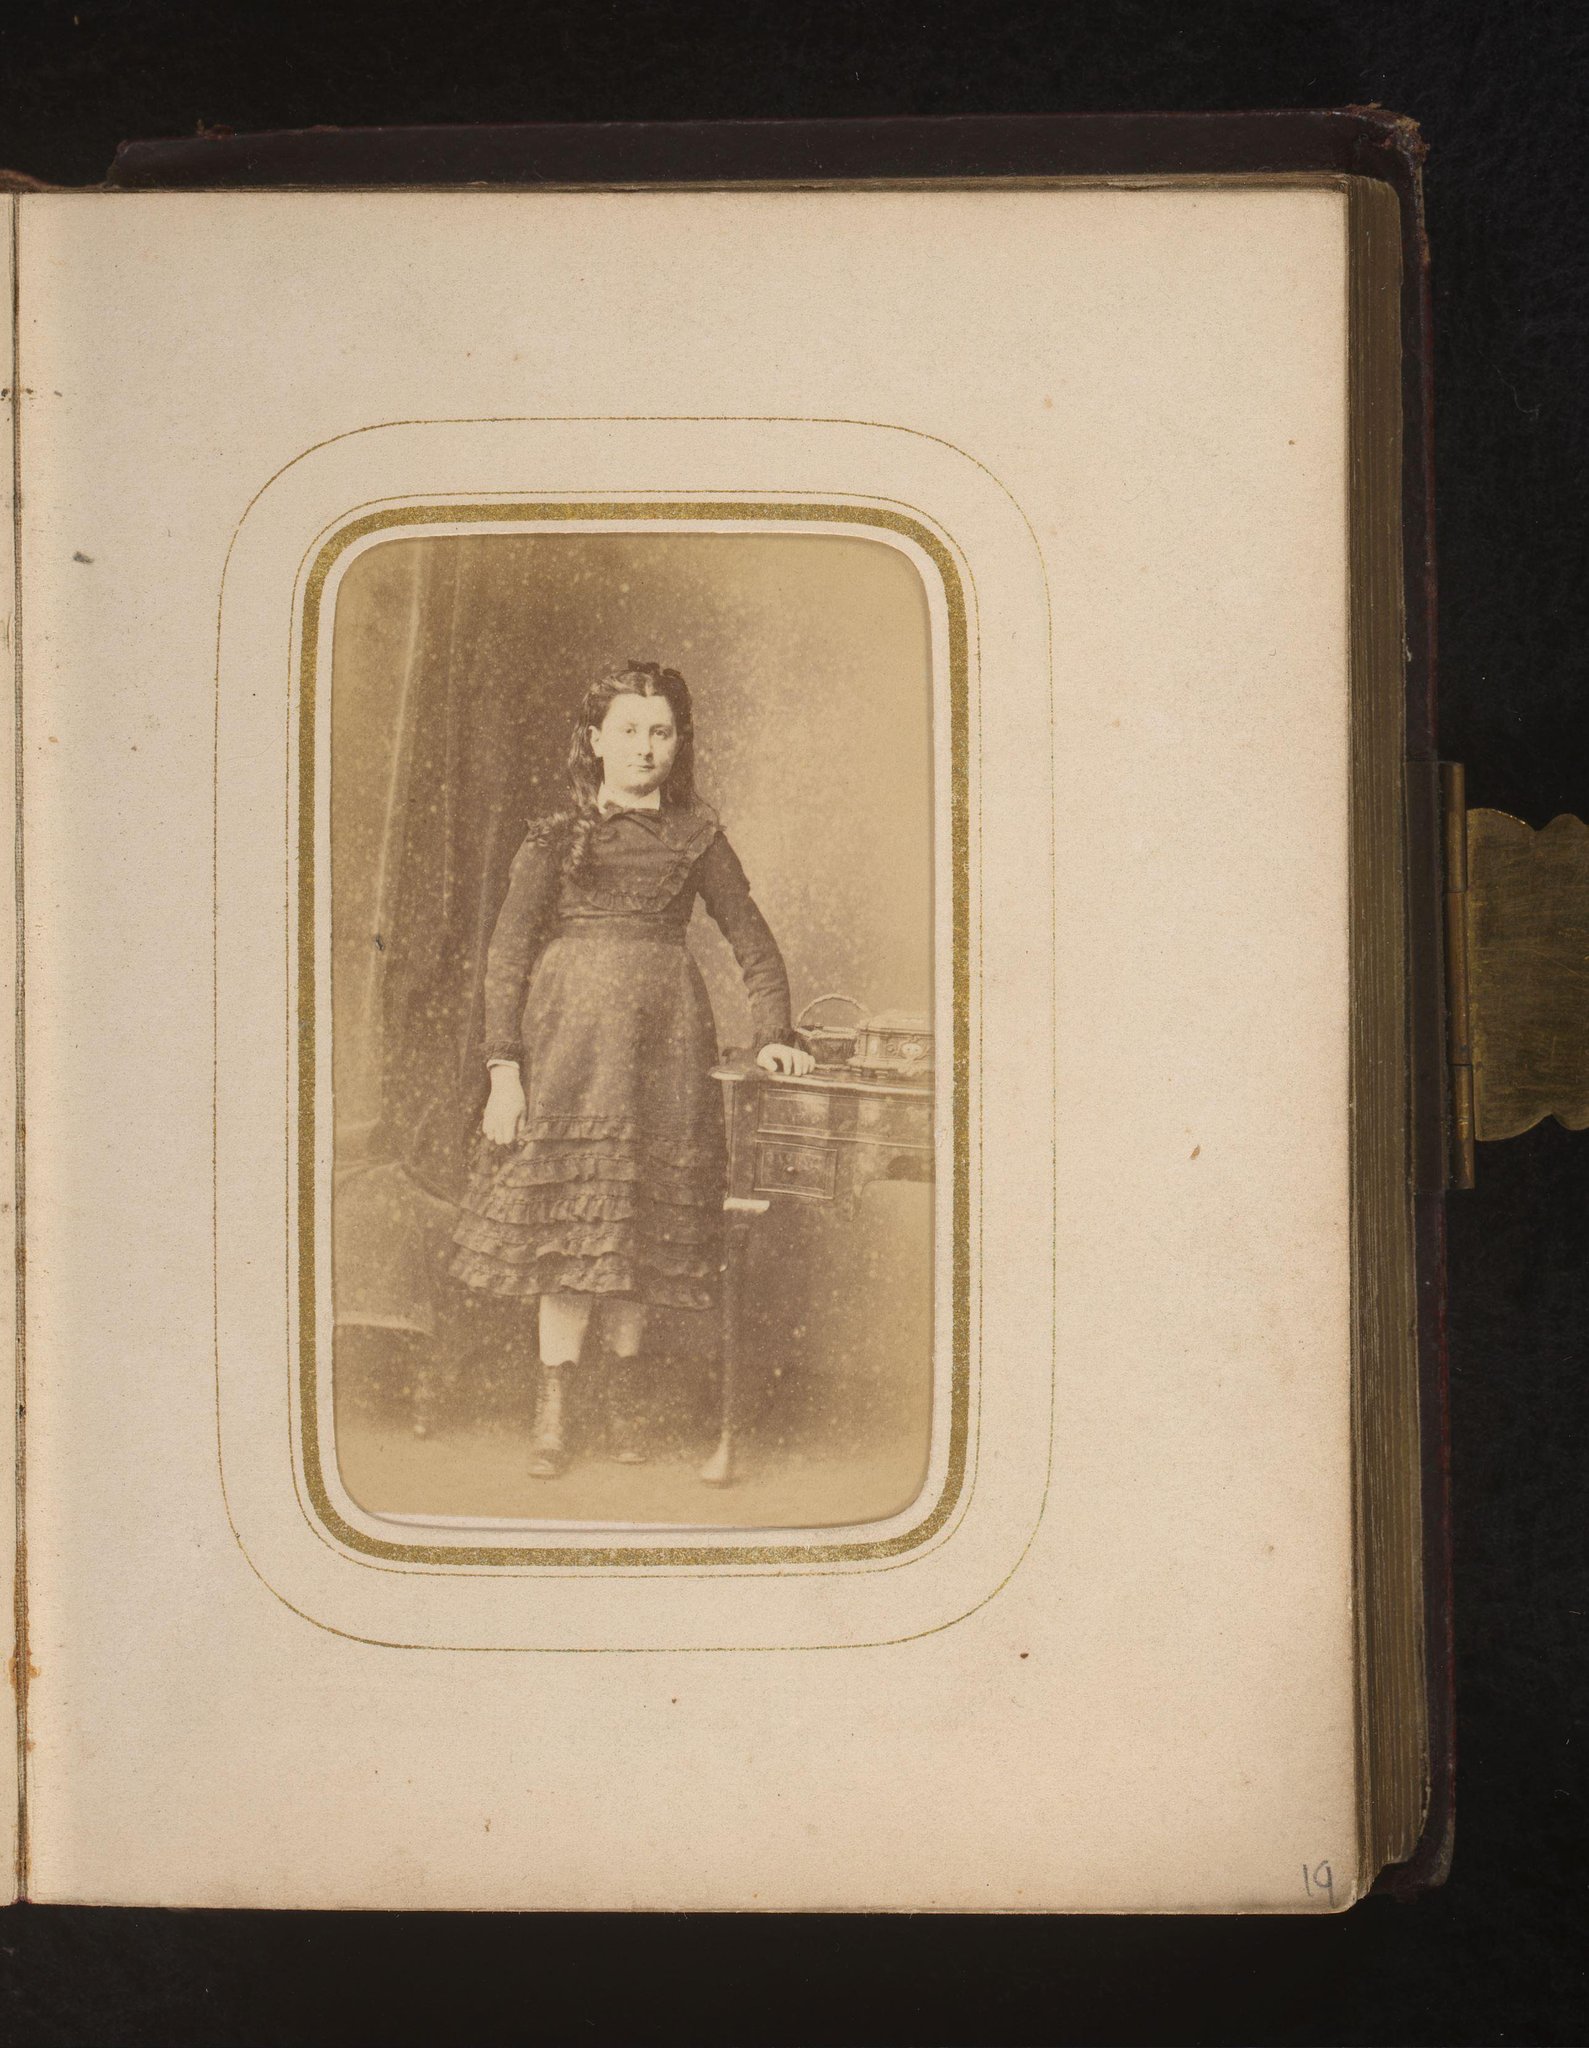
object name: photograph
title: Portret van een meisje, staand bij een bureau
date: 1860-1890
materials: cardboard, photographic support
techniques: albumen print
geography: paris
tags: girl (child between toddler and youth)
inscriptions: inscription: ‘Photogrpahie/ Bertall/ & Cie./ Rue Boissy d'Anglas, 33/ Ancienne Rue de la Madeleine’